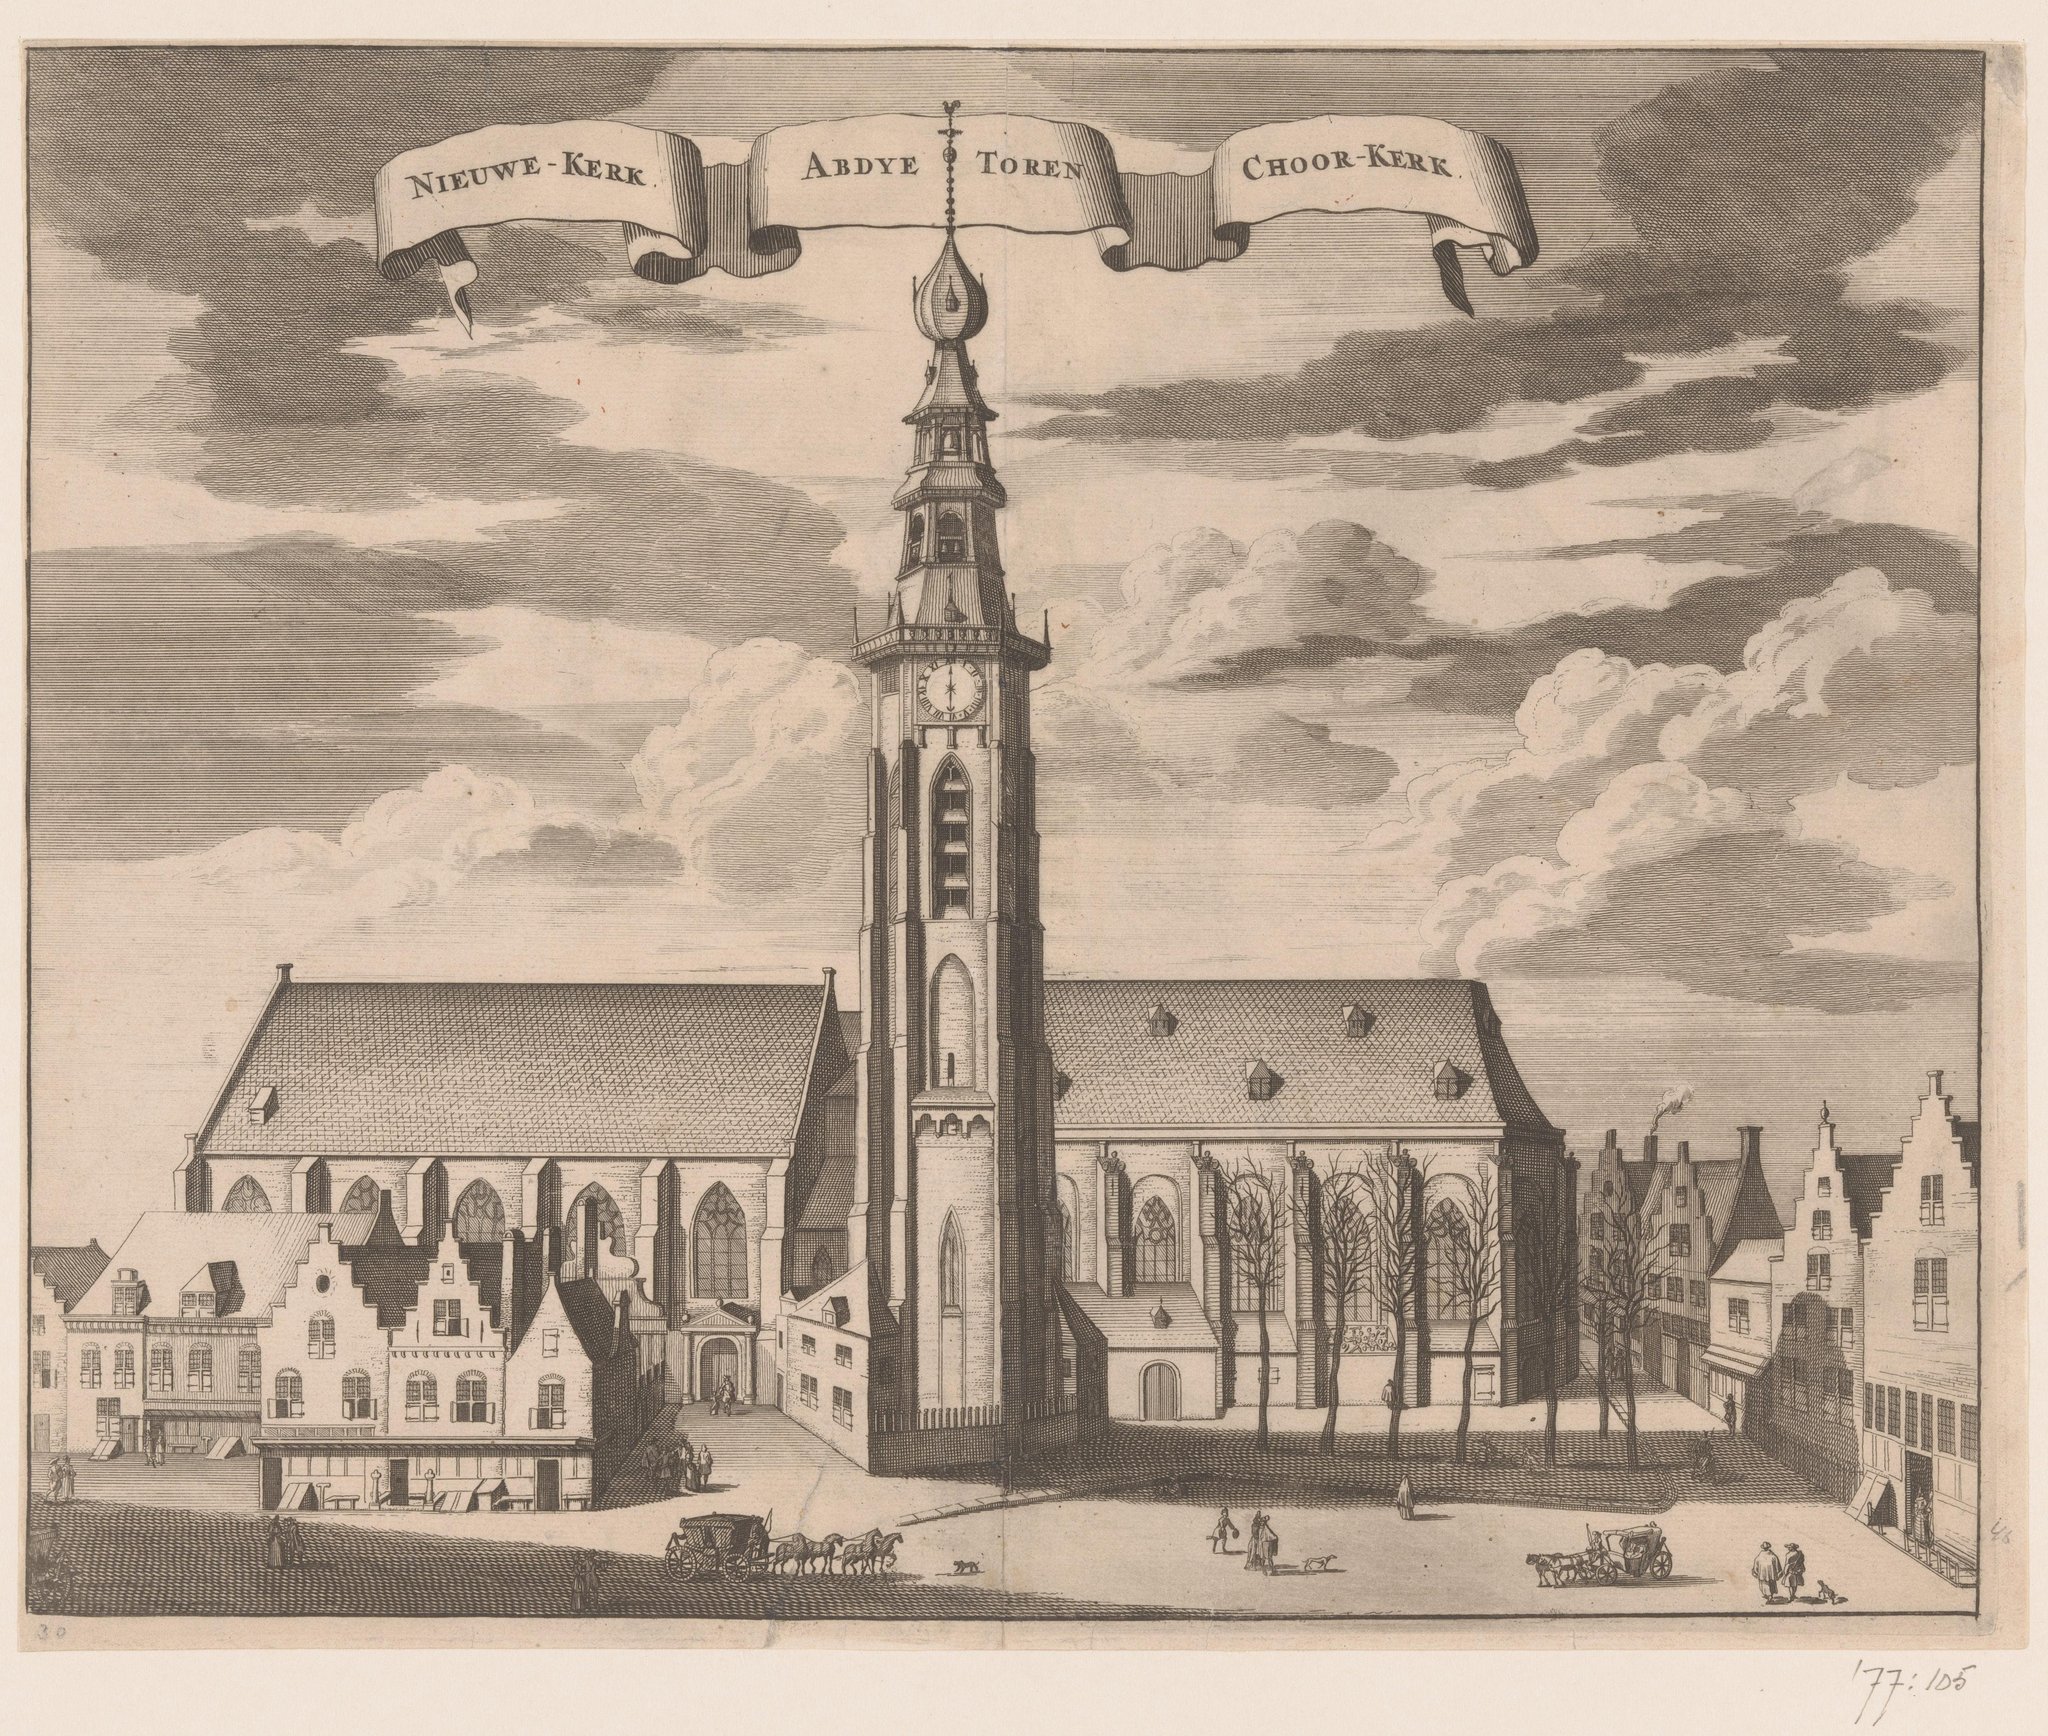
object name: book illustration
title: Nieuwe-Kerk, Abdye Toren, Choor-Kerk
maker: Anonymous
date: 1696-1728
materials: paper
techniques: etching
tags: church (exterior), parts of church exterior and annexes: tower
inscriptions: collector's mark: Lugt 2228, collector's mark: Lugt 2760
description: Prent in eerste staat (rechtsboven genummerd) verschenen in: Smallegange, Mattheus. Nieuwe Cronyk van Zeeland (…). Middelburg en Amsterdam: Johannes Meertens en Abraham van Someren, 1696. In tweede staat gemerkt Pag. Pars. VI en verschenen in: Heussen, Hugo Franciscus van. Oudheden en gestichten van Zeeland (…). Leiden: Christiaan Vermey, 1722, dl. 1. En in: Aa, Pieter van der. La galerie agreable du monde (...). Leiden: Pieter van der Aa, 1728, dl. 20. Omdat de plaatrand van de prent is afgesneden is niet na te gaan om welke staat het hier gaat.